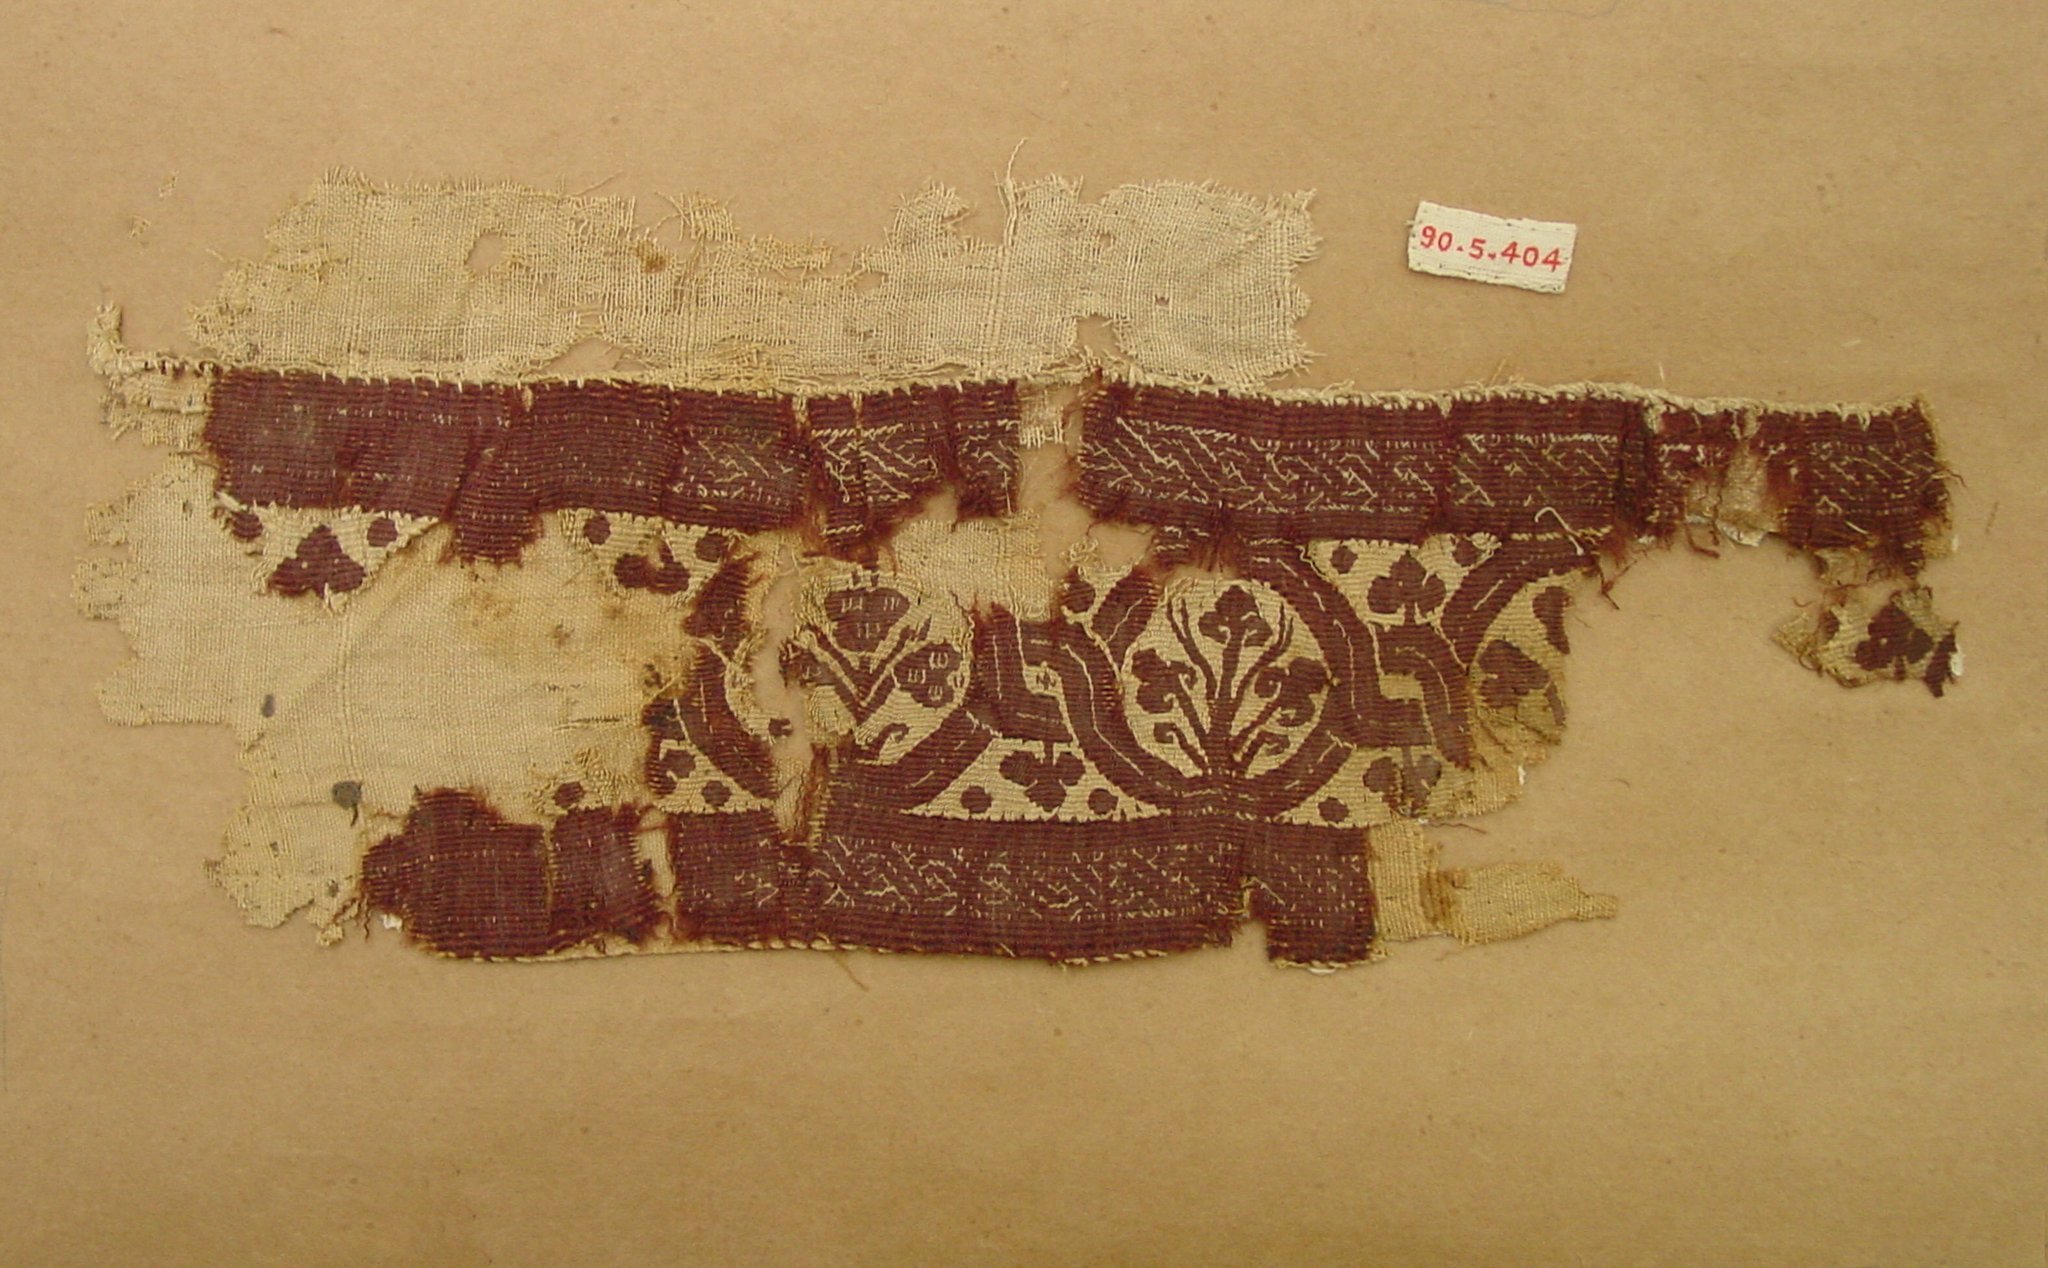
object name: textile fragment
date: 201-400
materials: linen, wool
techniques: weave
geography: egypt